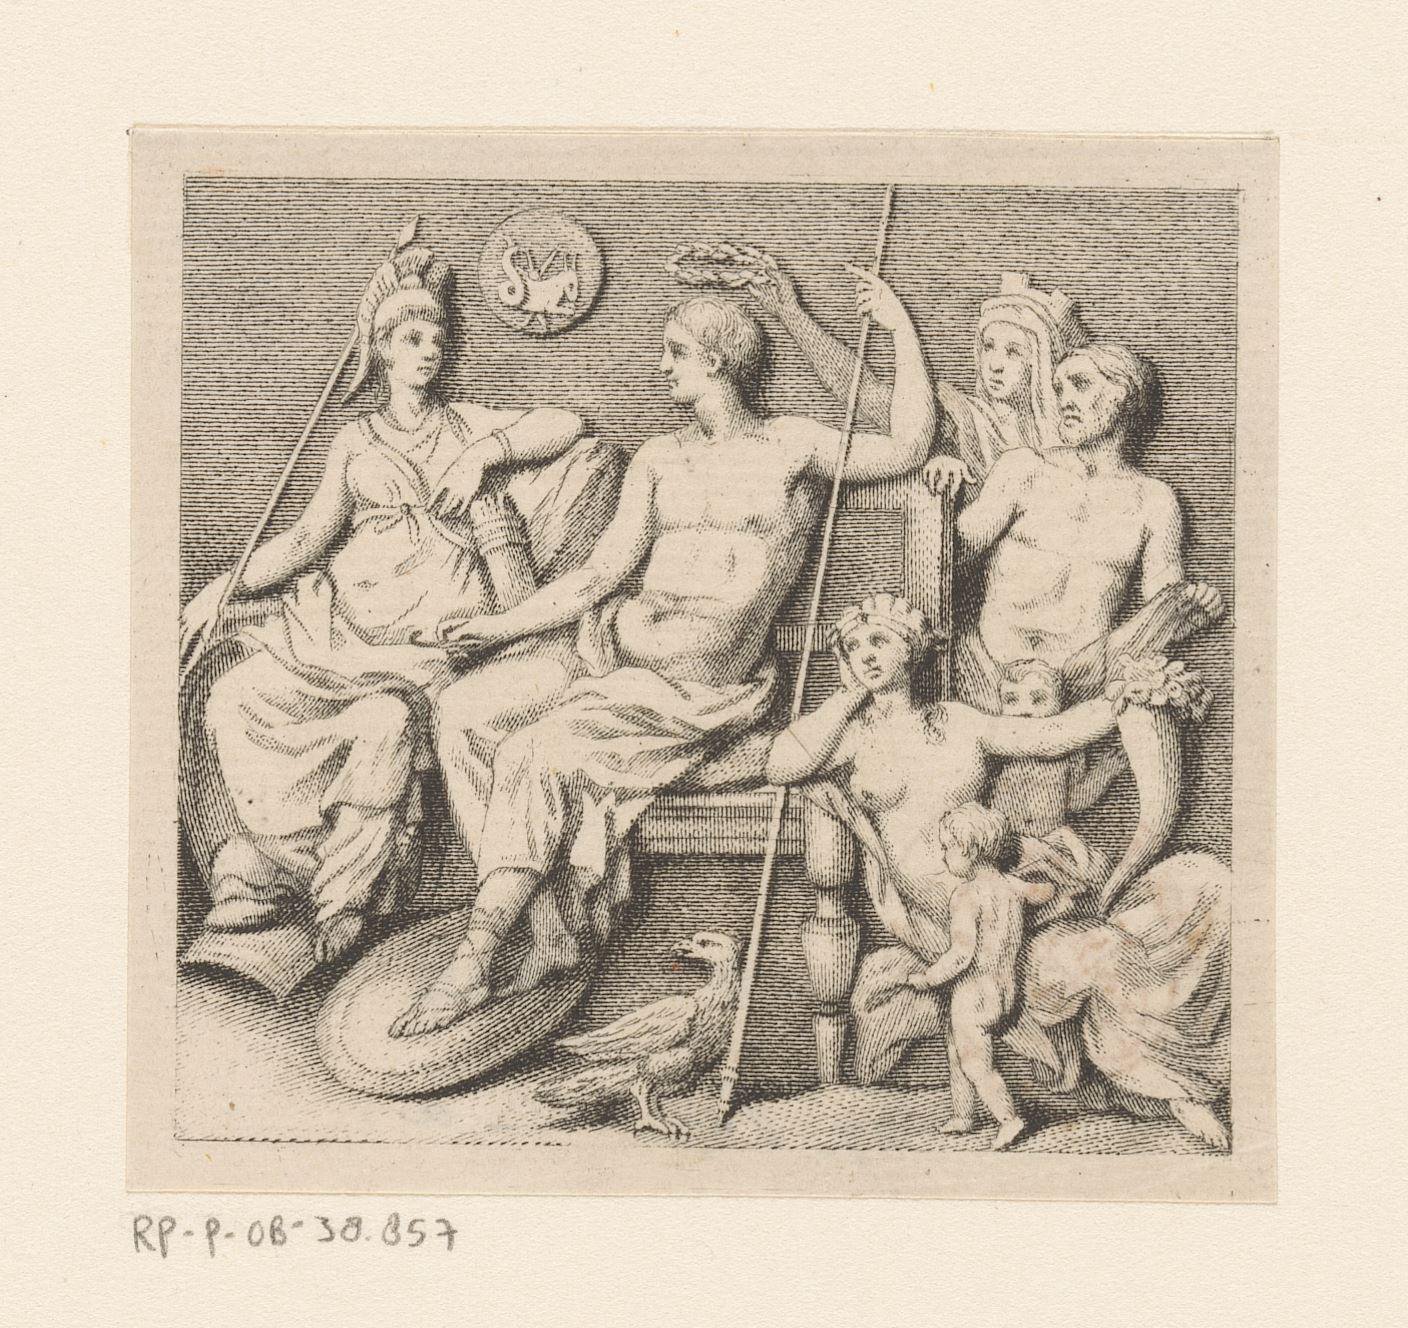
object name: print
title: Man wordt gelauwerd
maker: giovanni marco pitteri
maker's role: print maker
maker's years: 1702-1786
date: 1757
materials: paper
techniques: engraving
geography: italy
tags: predatory birds: eagle, (story of) minerva (pallas, athena), crowning with laurel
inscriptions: collector's mark: Lugt 240, inscription: ‘27. [...] 40. - a.’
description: Deze prent werd gebruikt als illustratie in een uitgave van de 'Ecloga' en 'Bucolica' van Vergilius. De editie werd geïllustreerd door Giovanni Marco Pitteri en uitgegeven in 1757 door Henrici Justice de Rufforth onder de titel: P. Virgilii Maronis Opera.